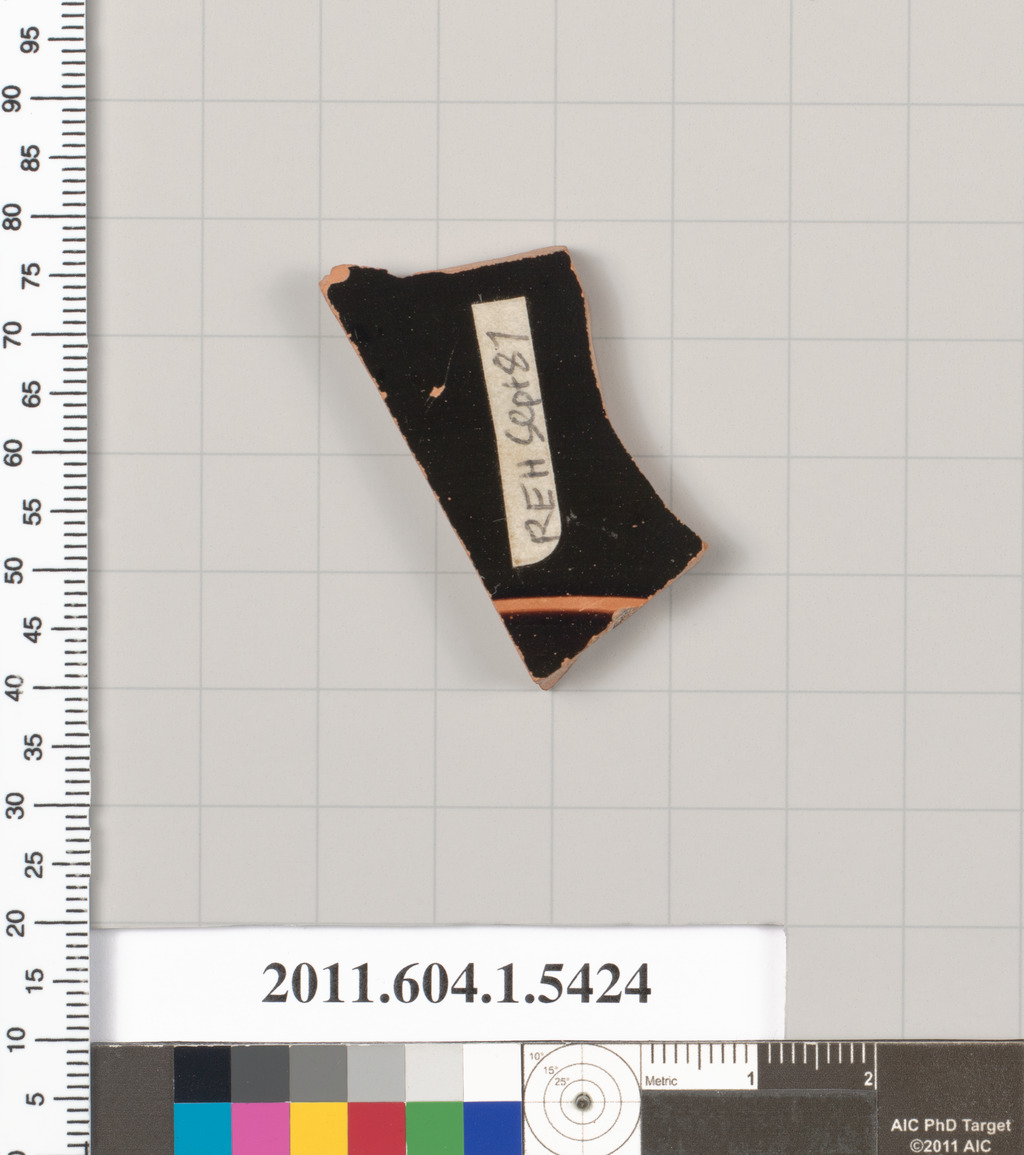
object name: kylix fragment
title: Terracotta fragment of a kylix (drinking cup)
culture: greek, attic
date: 500-480 BCE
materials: terracotta